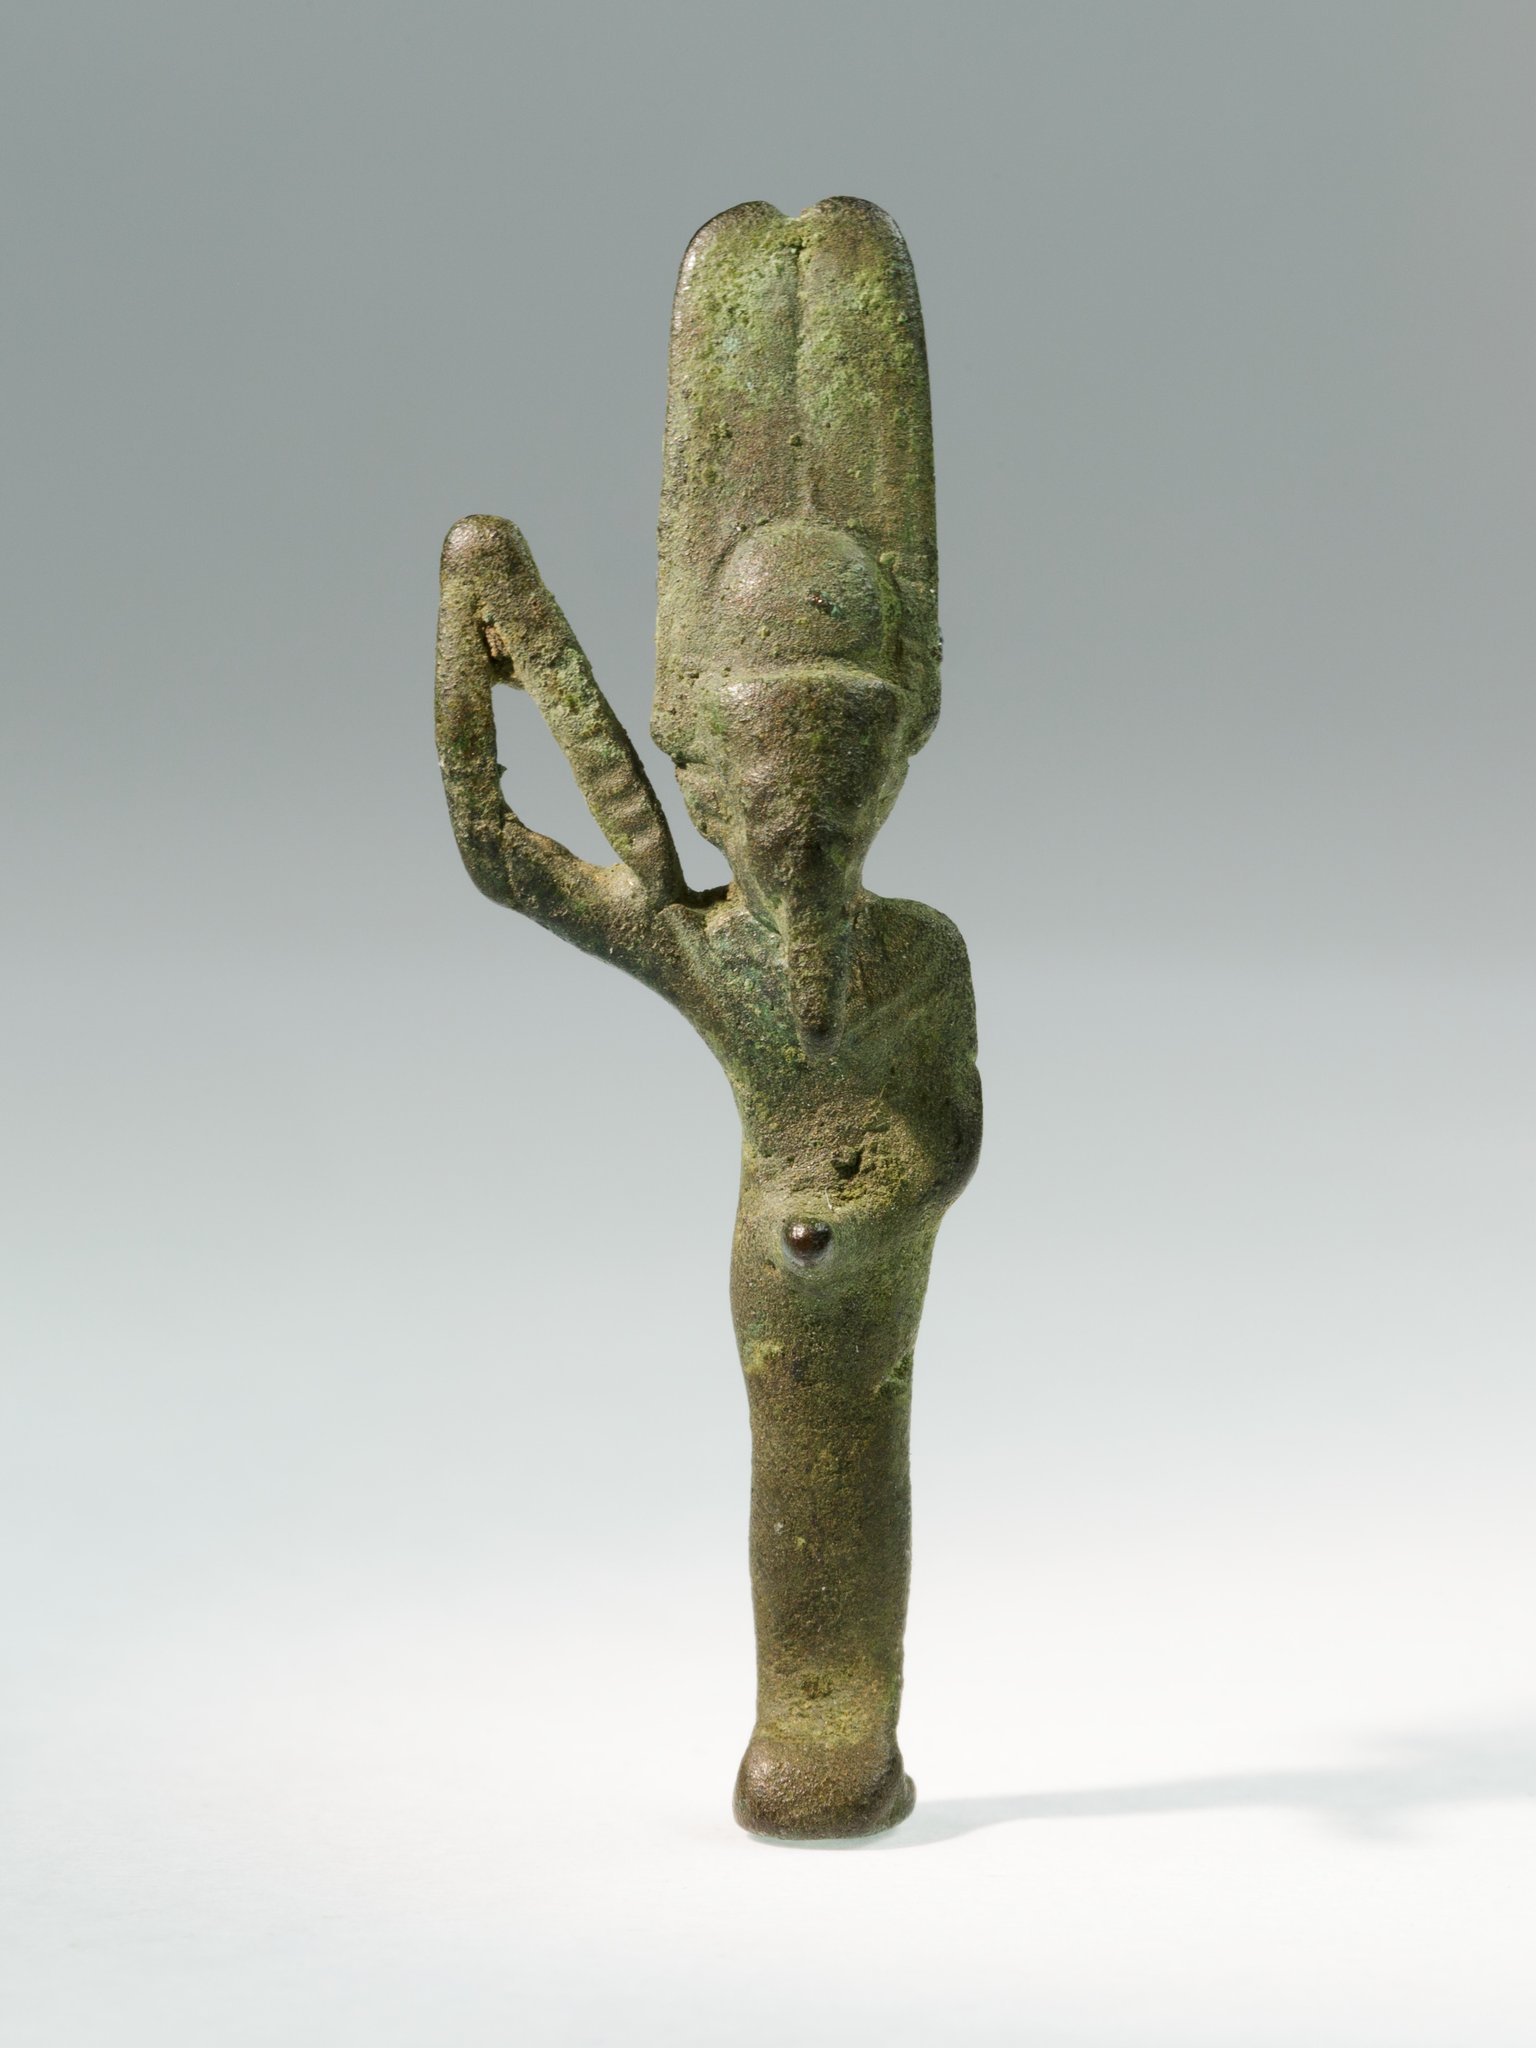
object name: amulet, min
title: Amulet of Min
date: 664-630 BCE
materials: alloy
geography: northern upper egypt